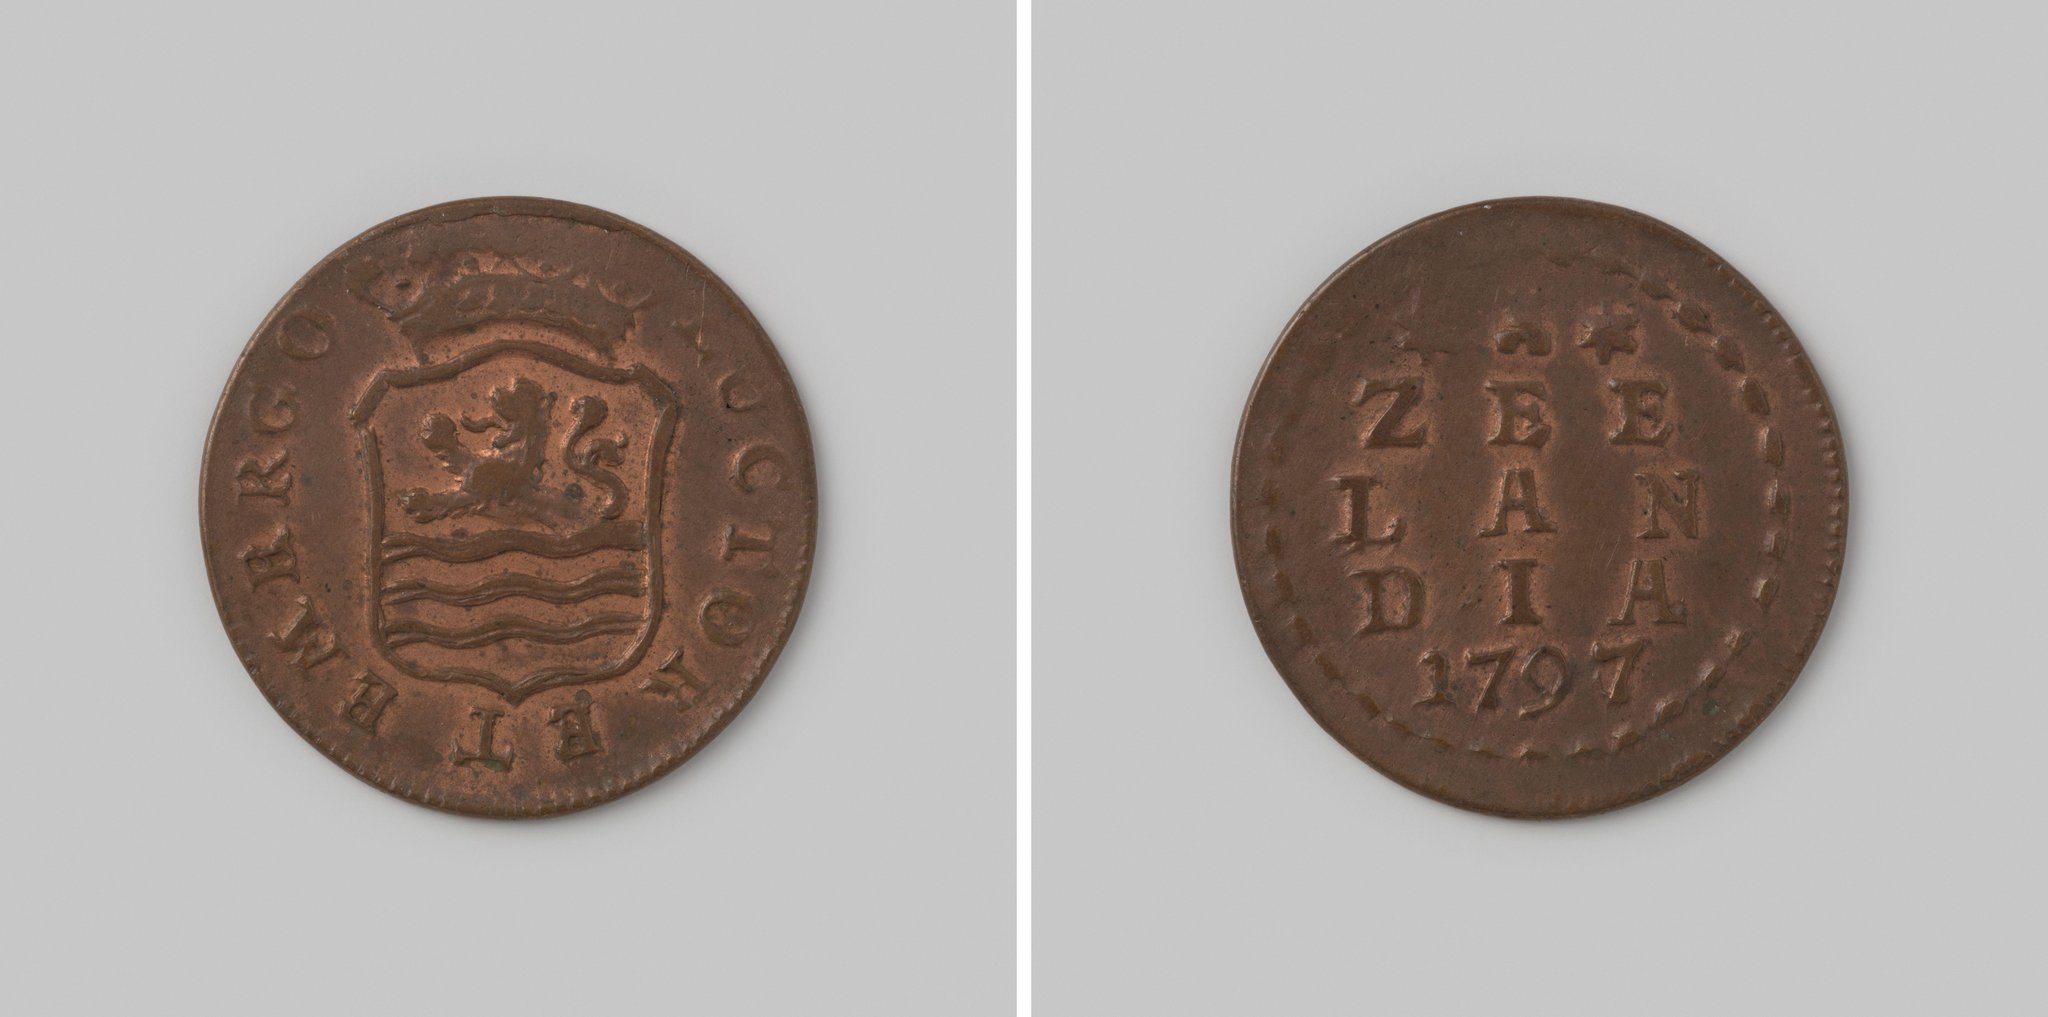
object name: coin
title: Bataafse Republiek, duit op naam van Zeeland, 1797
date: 1797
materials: copper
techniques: striking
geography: middelburg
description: Voorzijde: gekroond, zijdelings ingedeukt wapenschild van Zeeland. Keerzijde: in een krans opschrift in drie regels, waarboven muntteken burcht tussen twee sterren en waaronder jaartal.